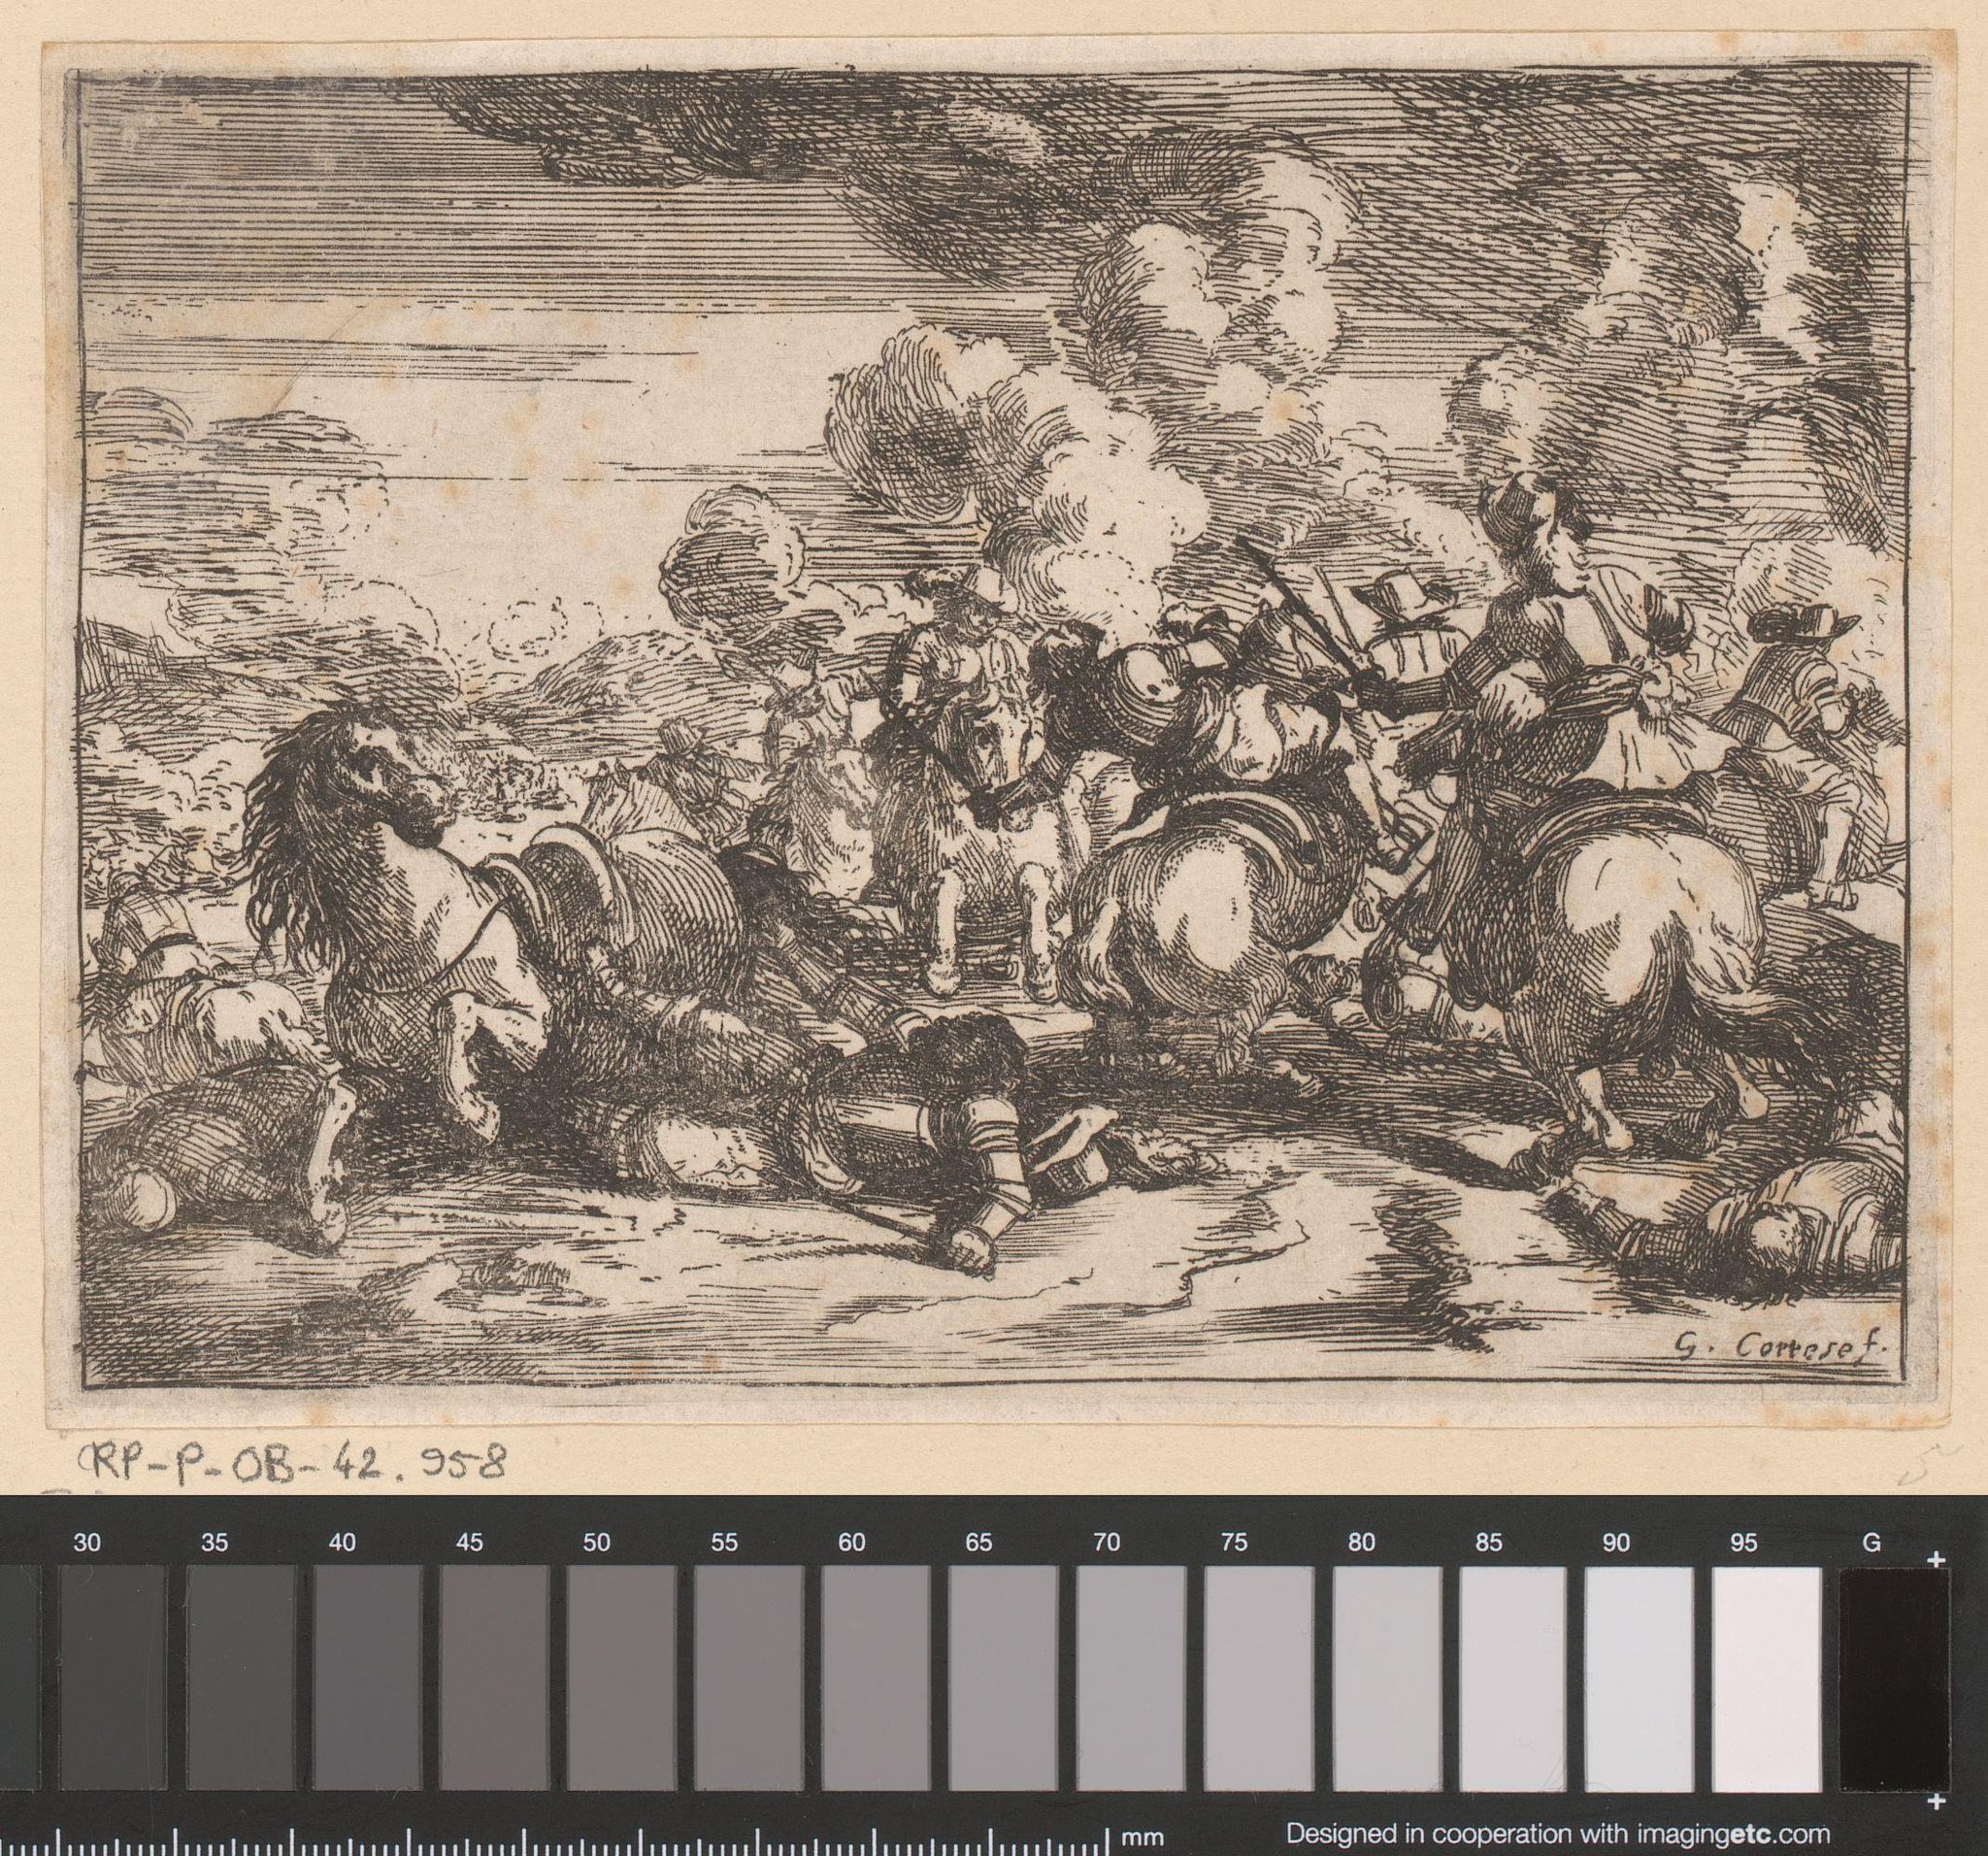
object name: print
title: Strijdgewoel met gewonde aanvoerder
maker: jacques courtois le bourguignon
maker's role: draughtsman, print maker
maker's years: 1621-1675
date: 1631-1675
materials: paper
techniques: etching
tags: battle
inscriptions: collector's mark: Lugt 240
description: Maakt deel uit van een achtdelige serie met veldslagen.